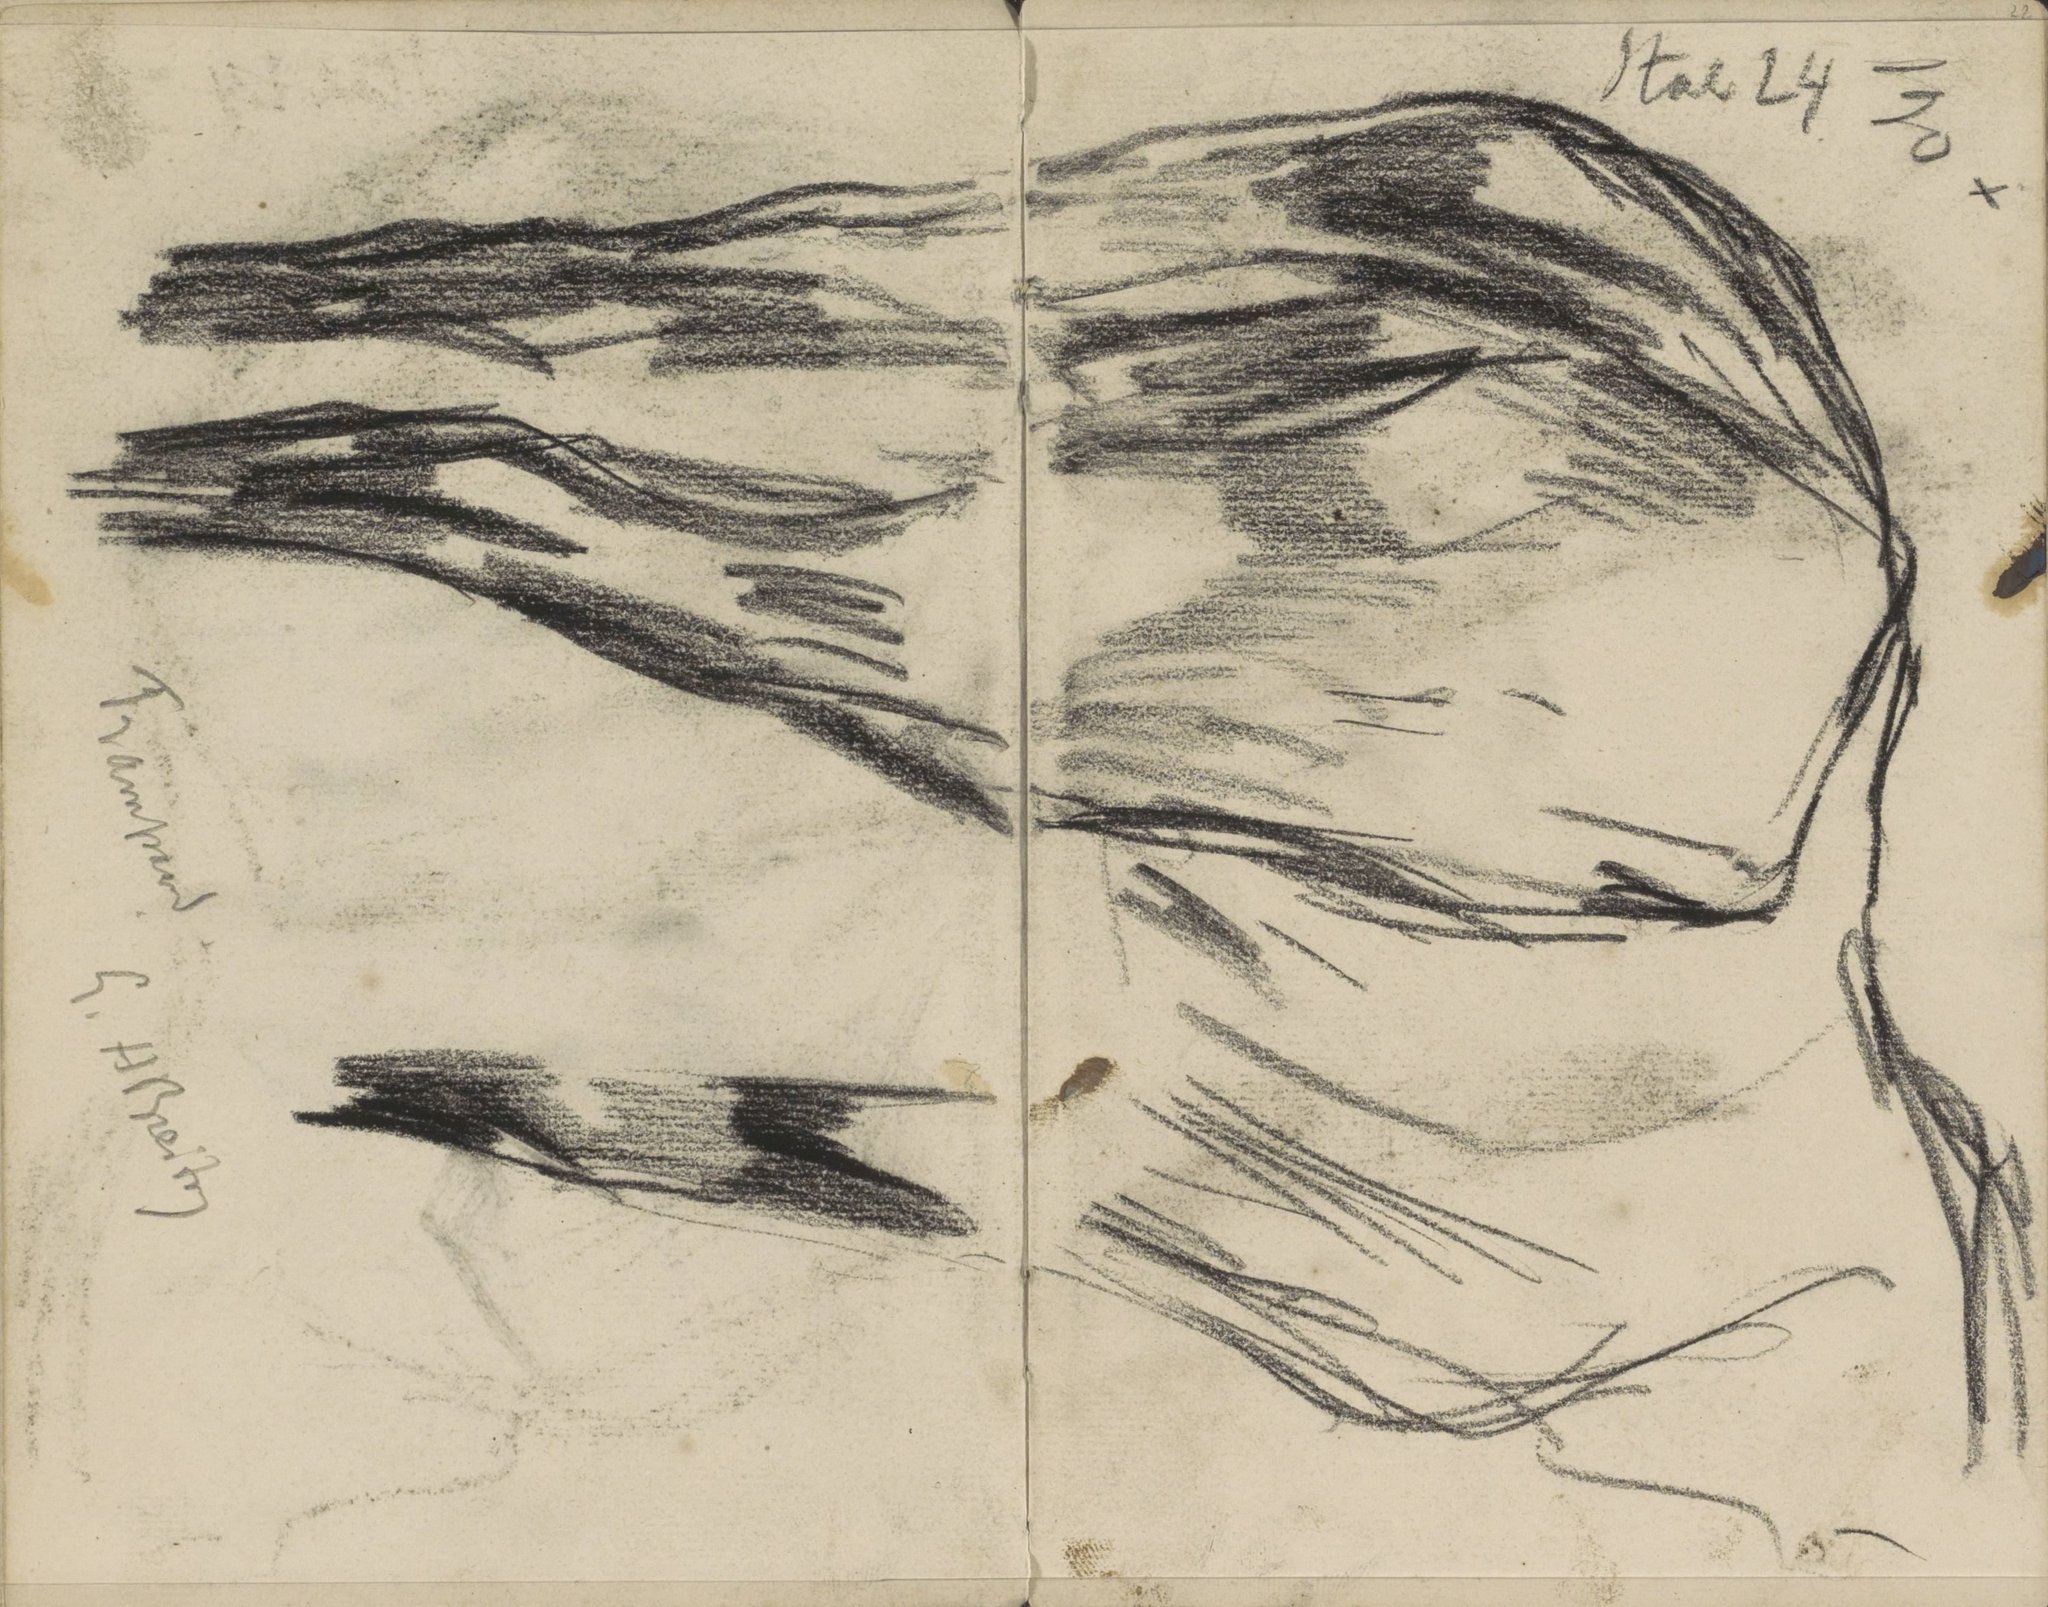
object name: sketchbook leaf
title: Trampaard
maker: george hendrik breitner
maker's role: draughtsman, painter, print maker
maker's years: 1857-1923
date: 1886-1903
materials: chalk, paper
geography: amsterdam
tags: horse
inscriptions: signature: ‘G.H Breitner’, annotation: ‘stal 24/ 190+/ Trampaard’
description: Pagina 21 en pagina 22 uit een schetsboek met 16 bladen.